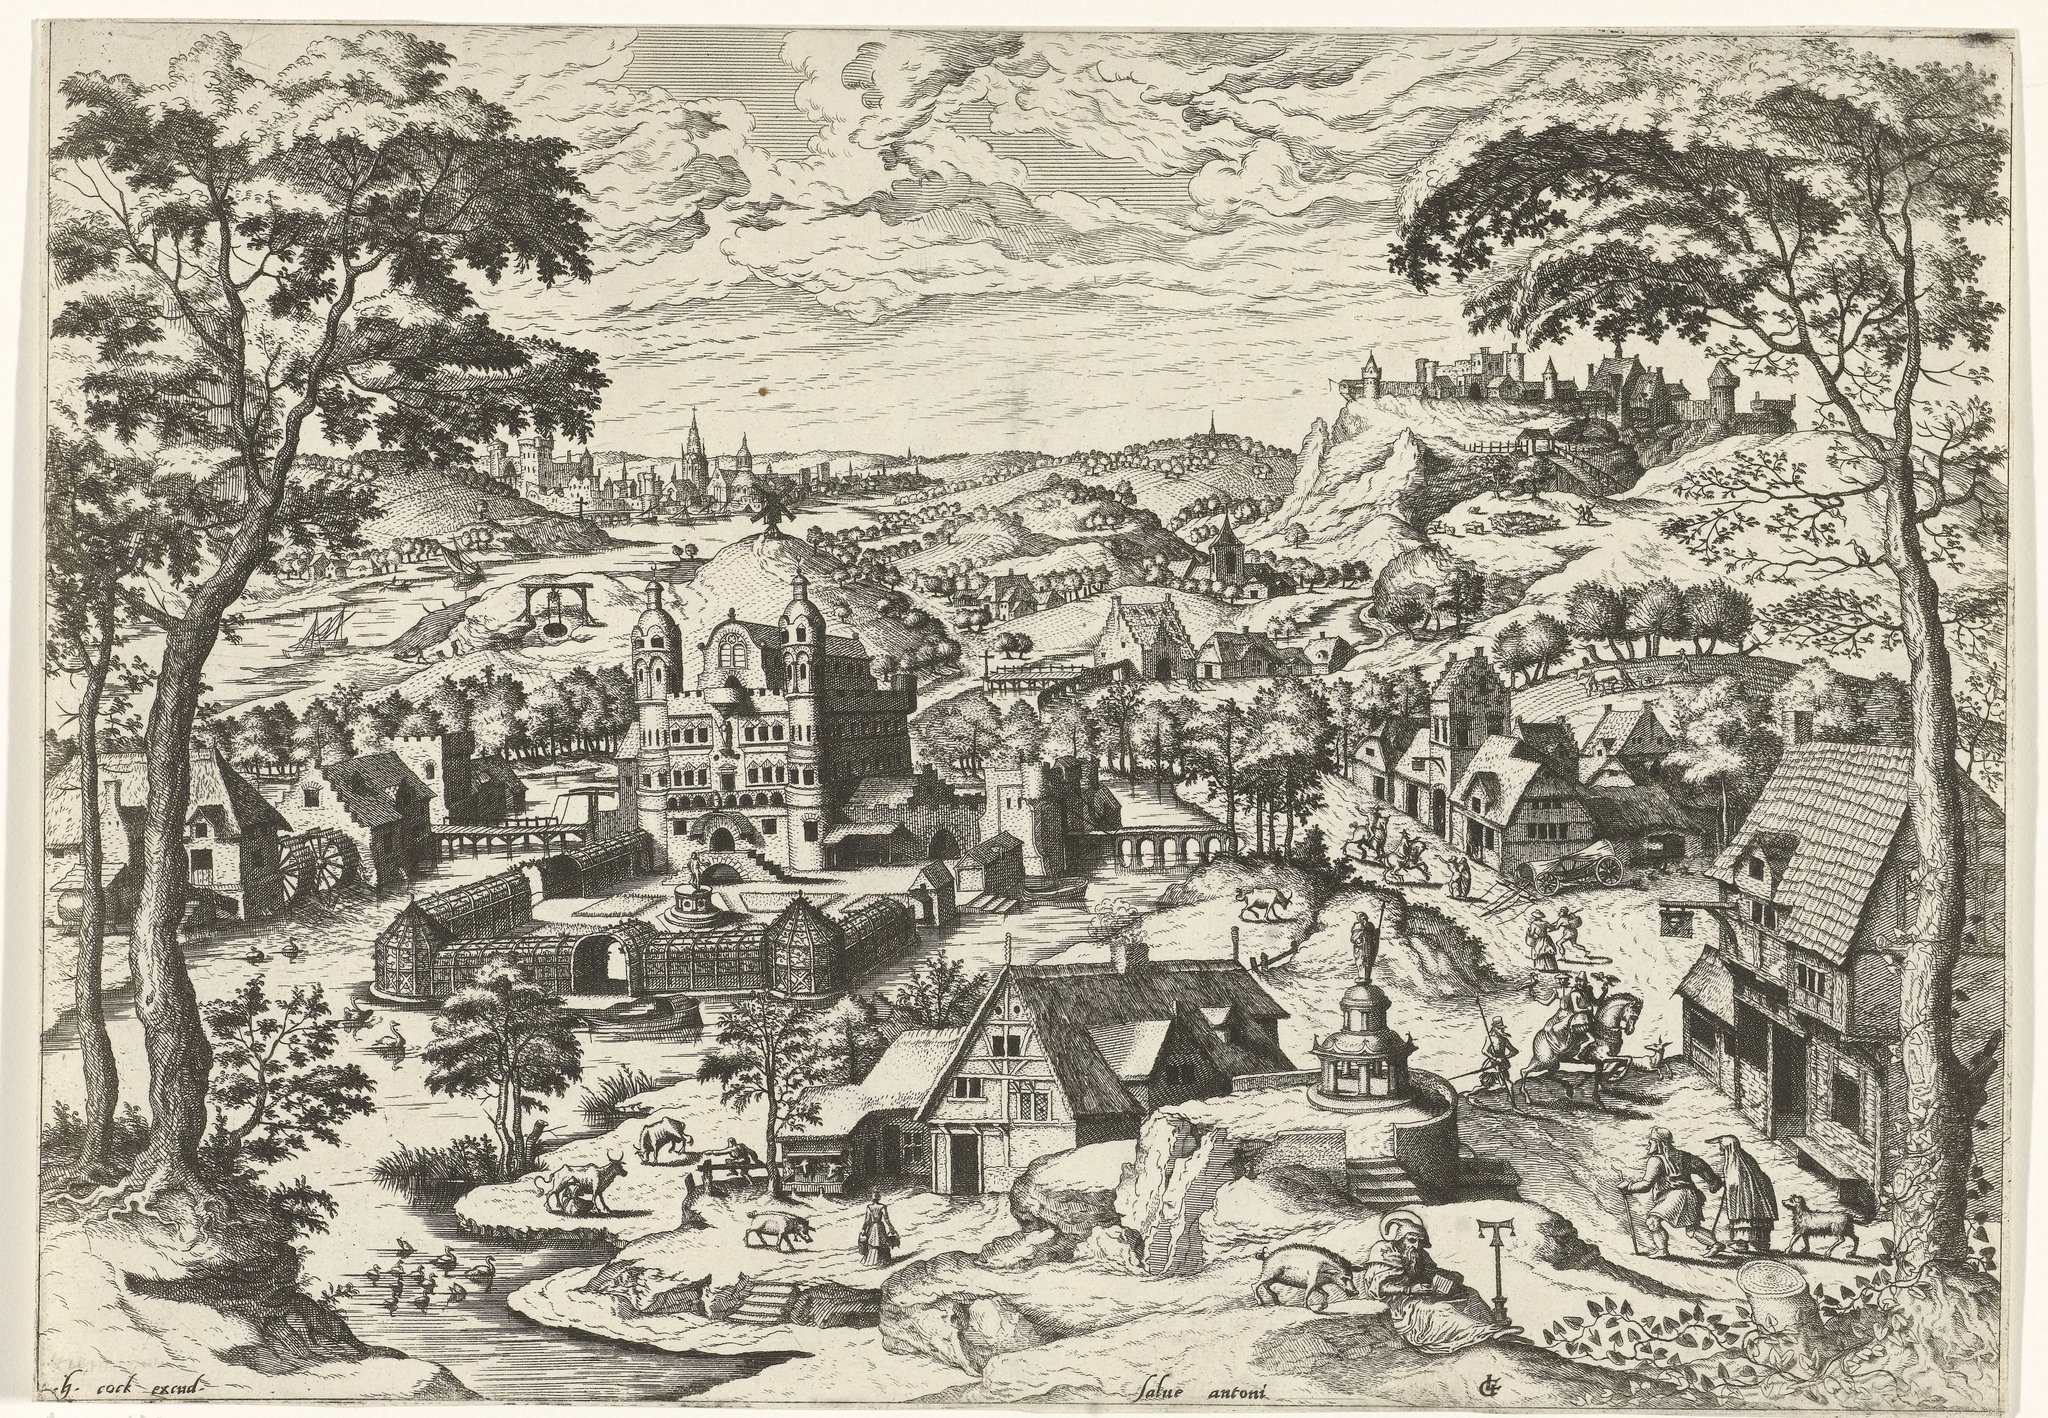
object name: print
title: Landschap met de heilige Antonius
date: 1560-1564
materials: paper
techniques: engraving, etching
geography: antwerp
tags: landscape with tower or castle (+ city(-scape) with figures, staffage), the hermit antony abbot (antonius abbas) of egypt, also called the great; possible attributes: bell, book, t-shaped staff, flames, pig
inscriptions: collector's mark: Lugt 845, collector's mark: Lugt 2166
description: Landschap met de heilige Antonius in de voorgrond. Hij bestudeert een bijbel. Naast hem zijn varken. Op de achtergrond een vallei met een stad in de verte. De prent is deel van een serie van landschappen met christelijke verhalen als thema.